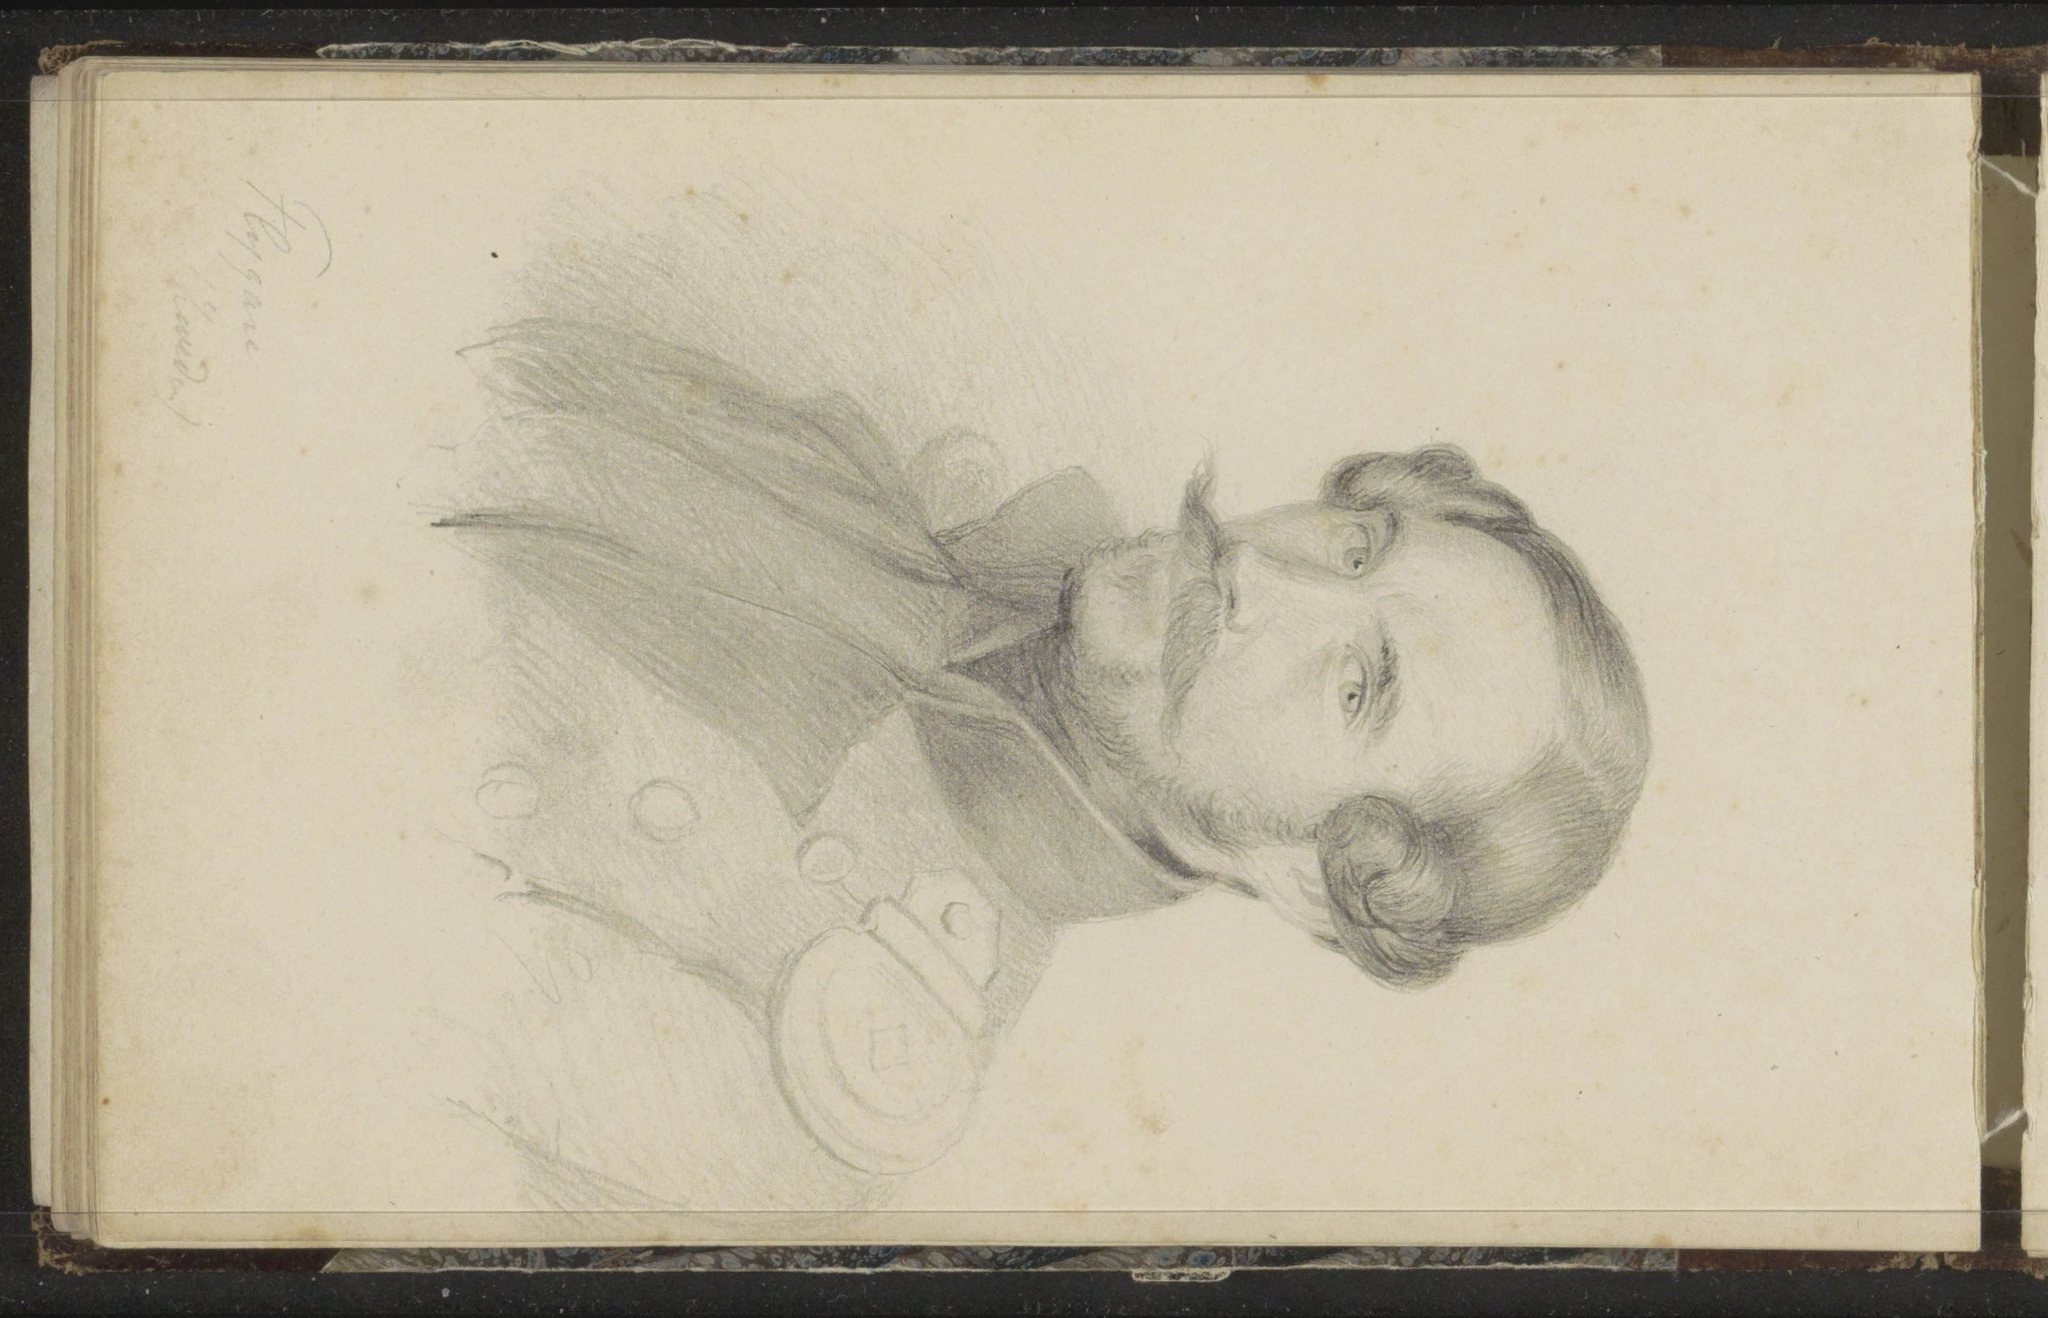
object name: sketchbook leaf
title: Portret van een Zweedse militair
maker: christian heinrich gottlieb steuerwald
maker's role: draughtsman, print maker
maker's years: 1802-1874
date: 1845-1848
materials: paper, pencil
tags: (military) uniforms, historical persons (portraits and scenes from the life)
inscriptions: annotation: ‘Flygare/ (Zweden)’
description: Blad 55 verso uit een schetsboek met 61 bladen.